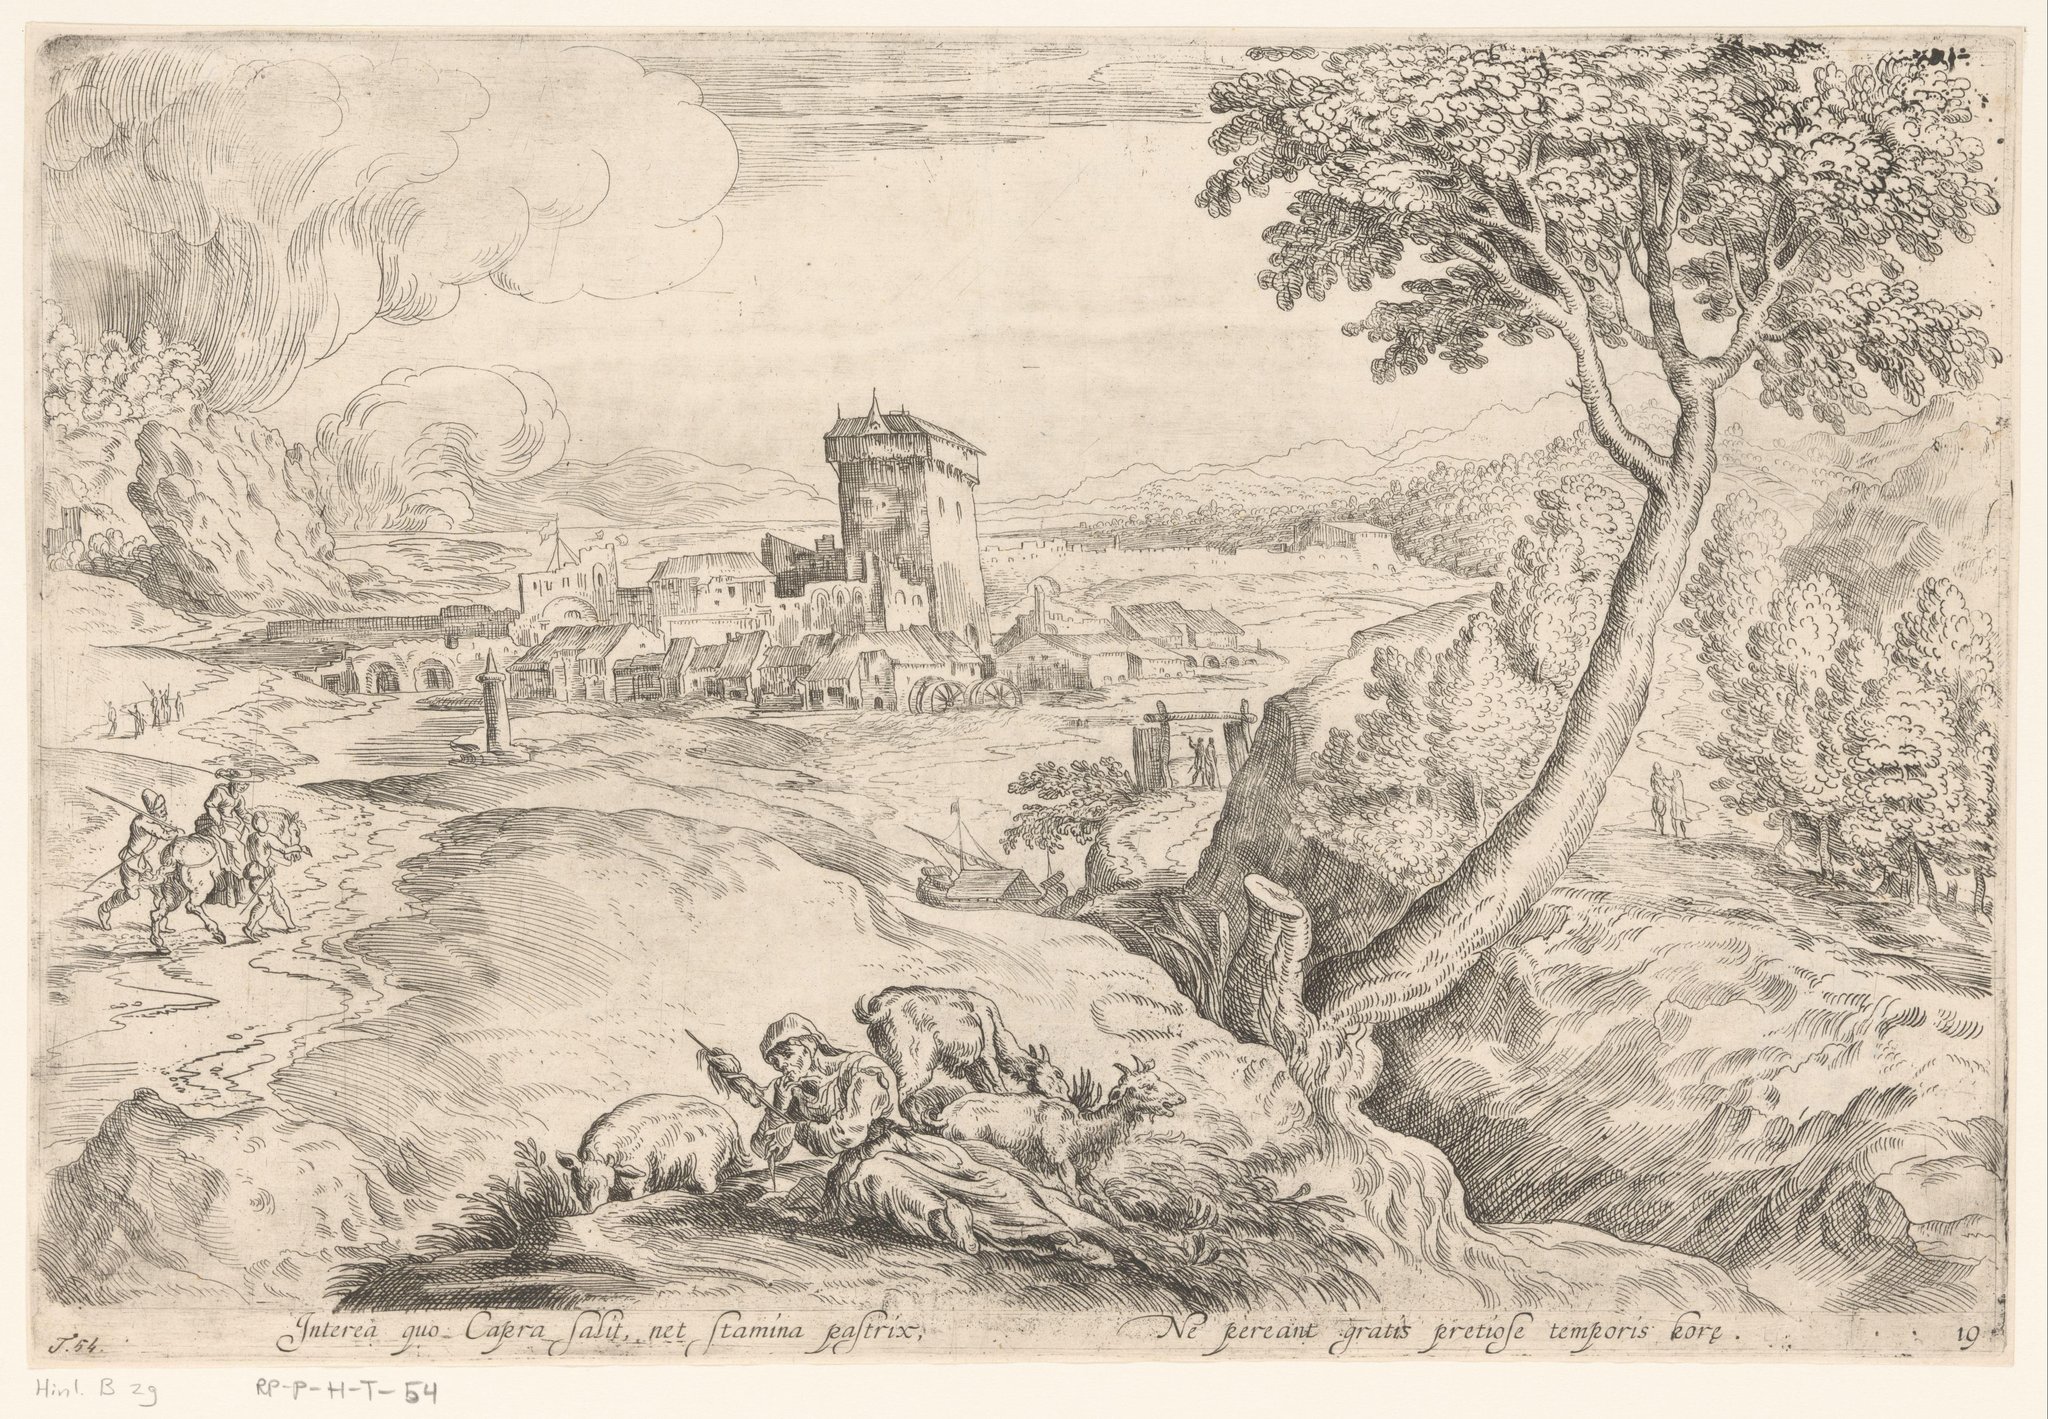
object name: print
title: Landschappen naar Domenico Campagnola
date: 1600-1699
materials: paper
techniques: etching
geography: italy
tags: landscapes, herding, herdsman, herdswoman, shepherd, shepherdess, cowherd, etc., spindle, herd, flock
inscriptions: collector's mark: Lugt 11, collector's mark: ‘Hinloopen’, number: ‘T. 54’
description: Landschap met een nederzetting en een stroom. Op de voorgrond ligt een spinnende herderin met drie geiten in het gras. Titel in het Latijn in ondermarge. Genummerd rechtsonder: 19.